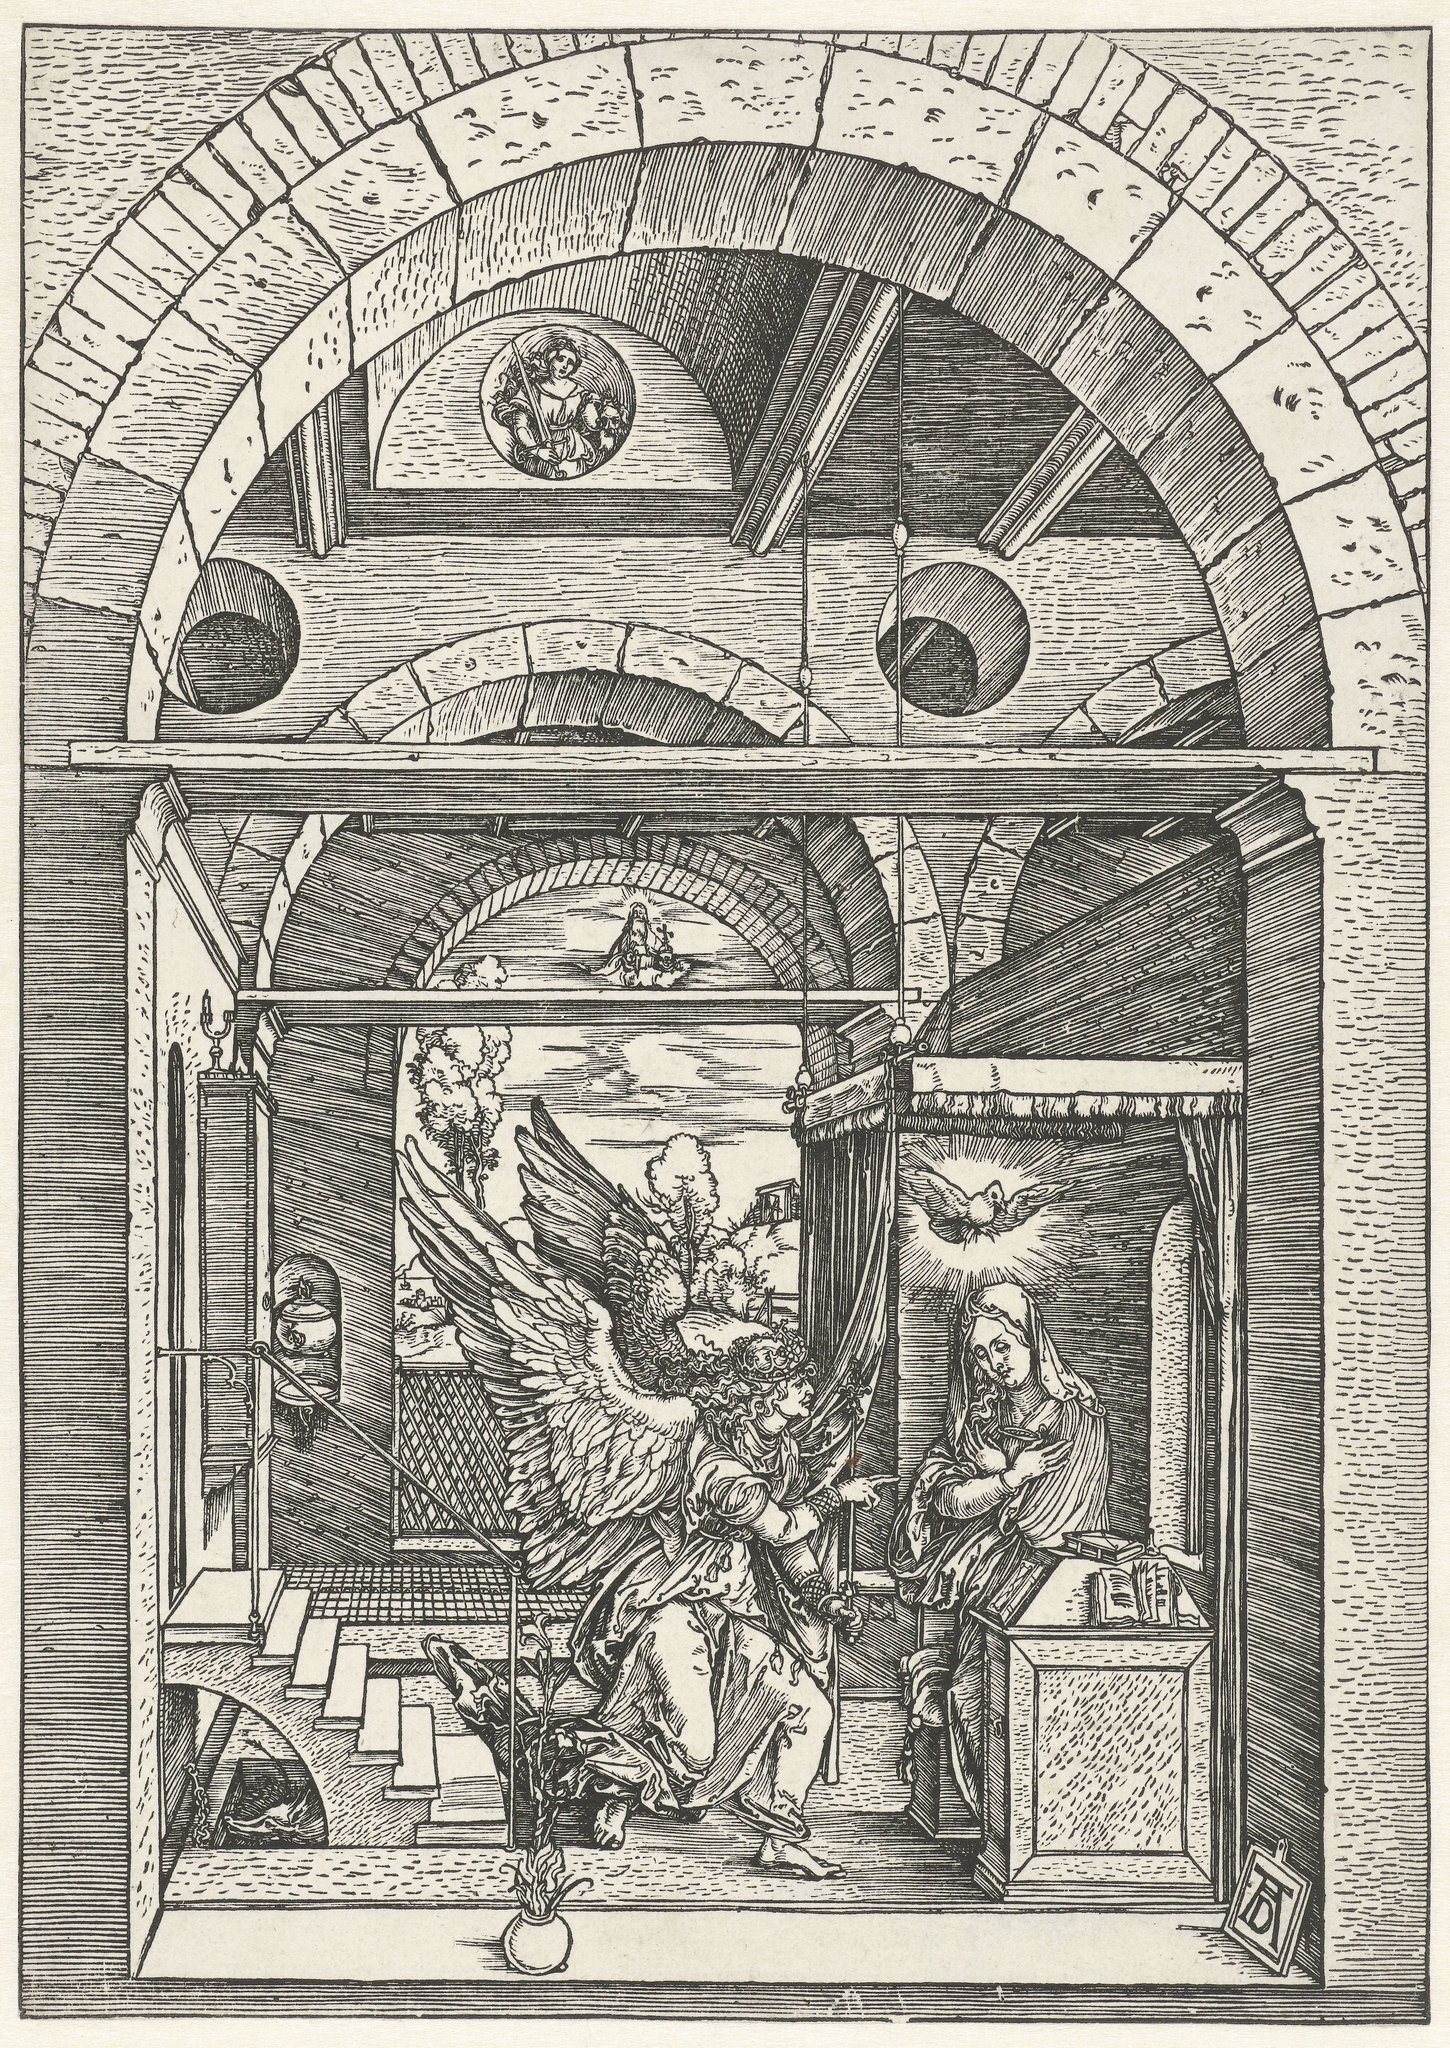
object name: print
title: Leven van Maria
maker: albrecht dürer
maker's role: draughtsman, painter, print maker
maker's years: 1471-1528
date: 1501-1505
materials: paper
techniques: woodcut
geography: nuremberg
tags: the annunciation: mary sitting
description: De engel Gabriël verschijnt aan Maria, terwijl zij zit te lezen aan een lezenaar in een hoog vertrek. Op de achtergrond God in de hemel; boven Maria's hoofd de Heilige Geest in de gedaante van een duif. Deze prent is onderdeel van een serie van 20 prenten, bestaand uit een titelprent en 19 prenten met scènes uit het leven van Maria.